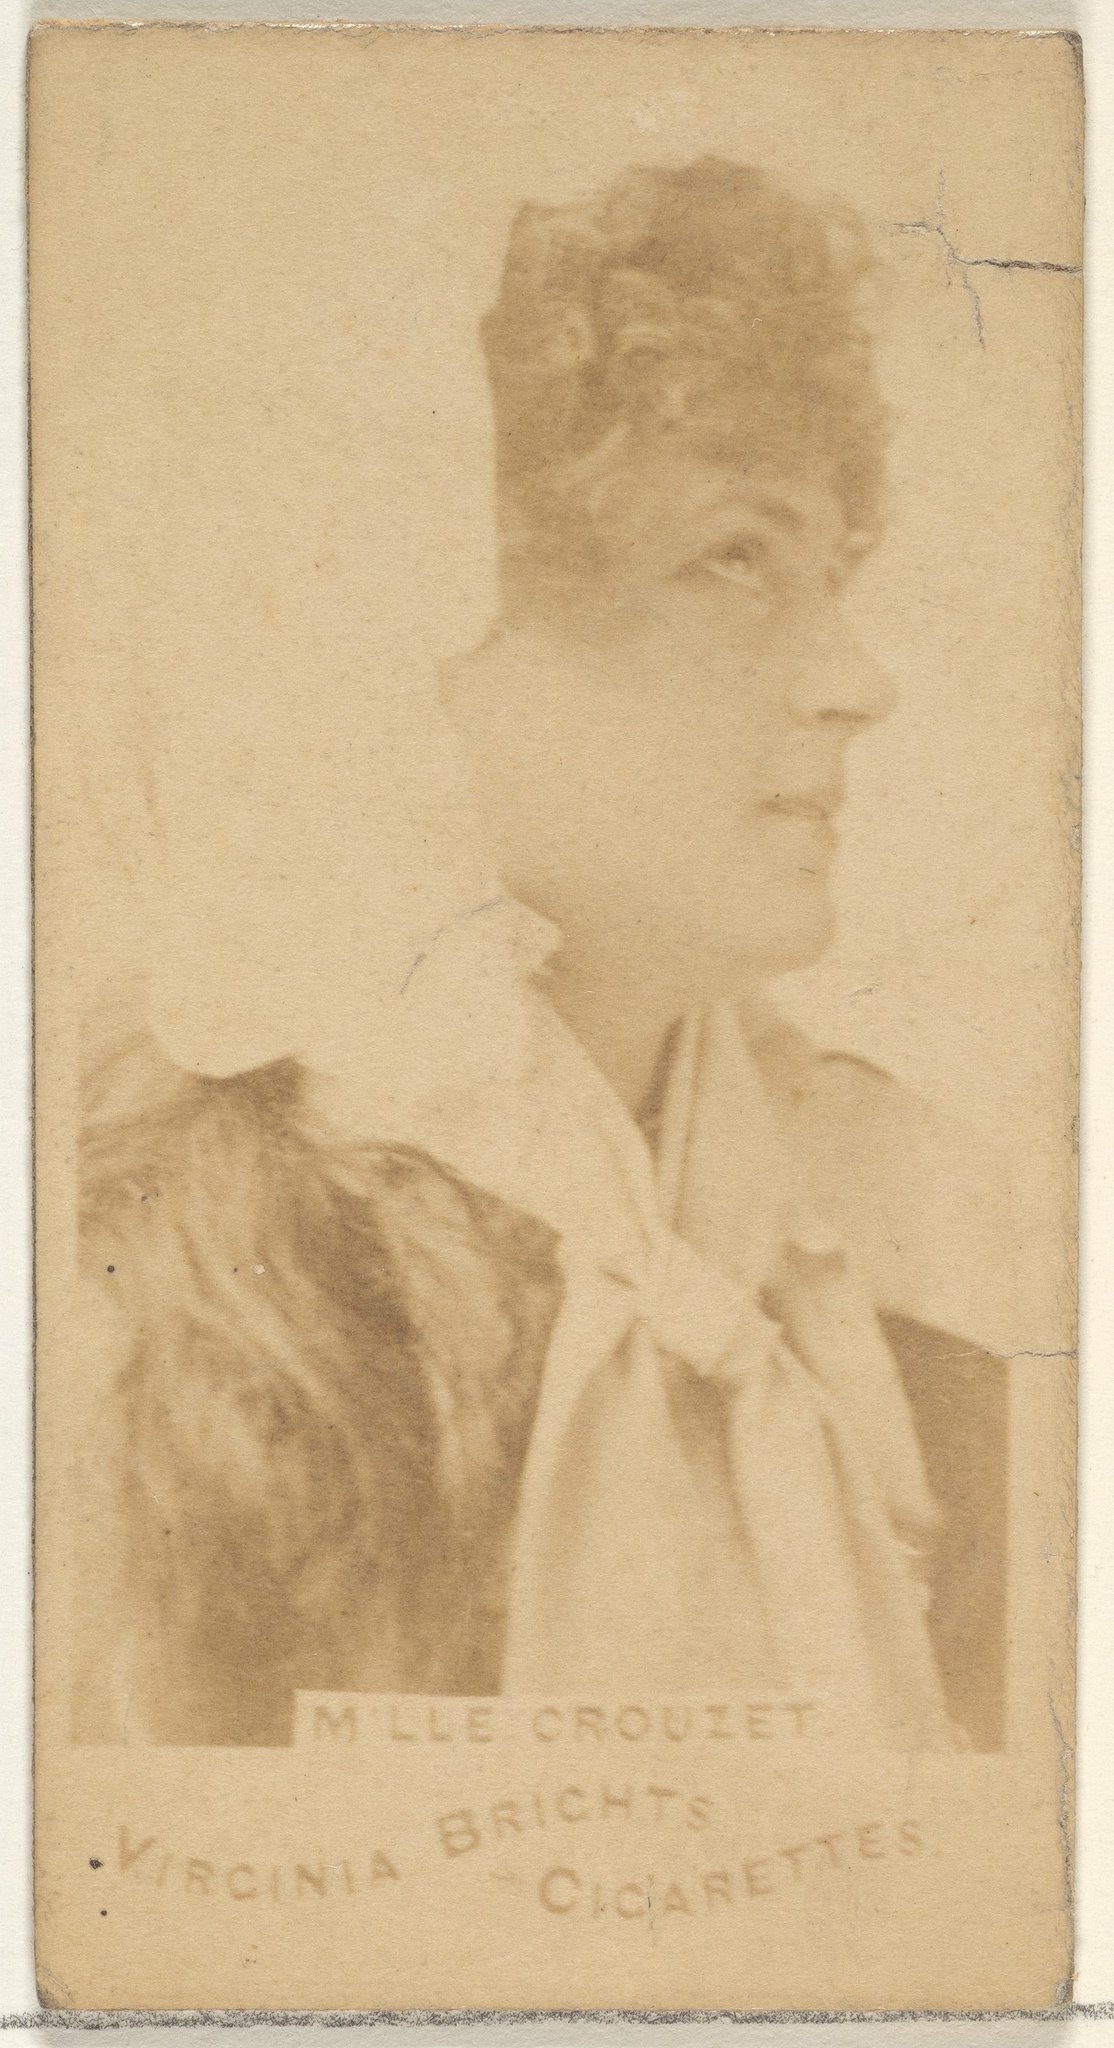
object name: photograph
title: Mlle. Crouzet, from the Actors and Actresses series (N45, Type 1) for Virginia Brights Cigarettes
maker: allen & ginter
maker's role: publisher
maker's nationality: american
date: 1888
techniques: albumen silver print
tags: portraits,profiles,women,actresses